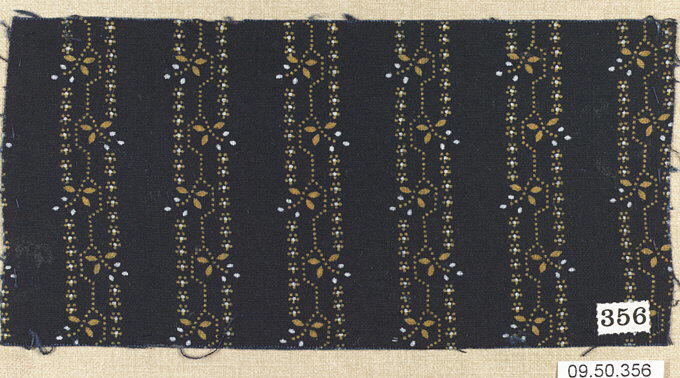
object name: piece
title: Piece (one of 116)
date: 1801-1900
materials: cotton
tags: leaves